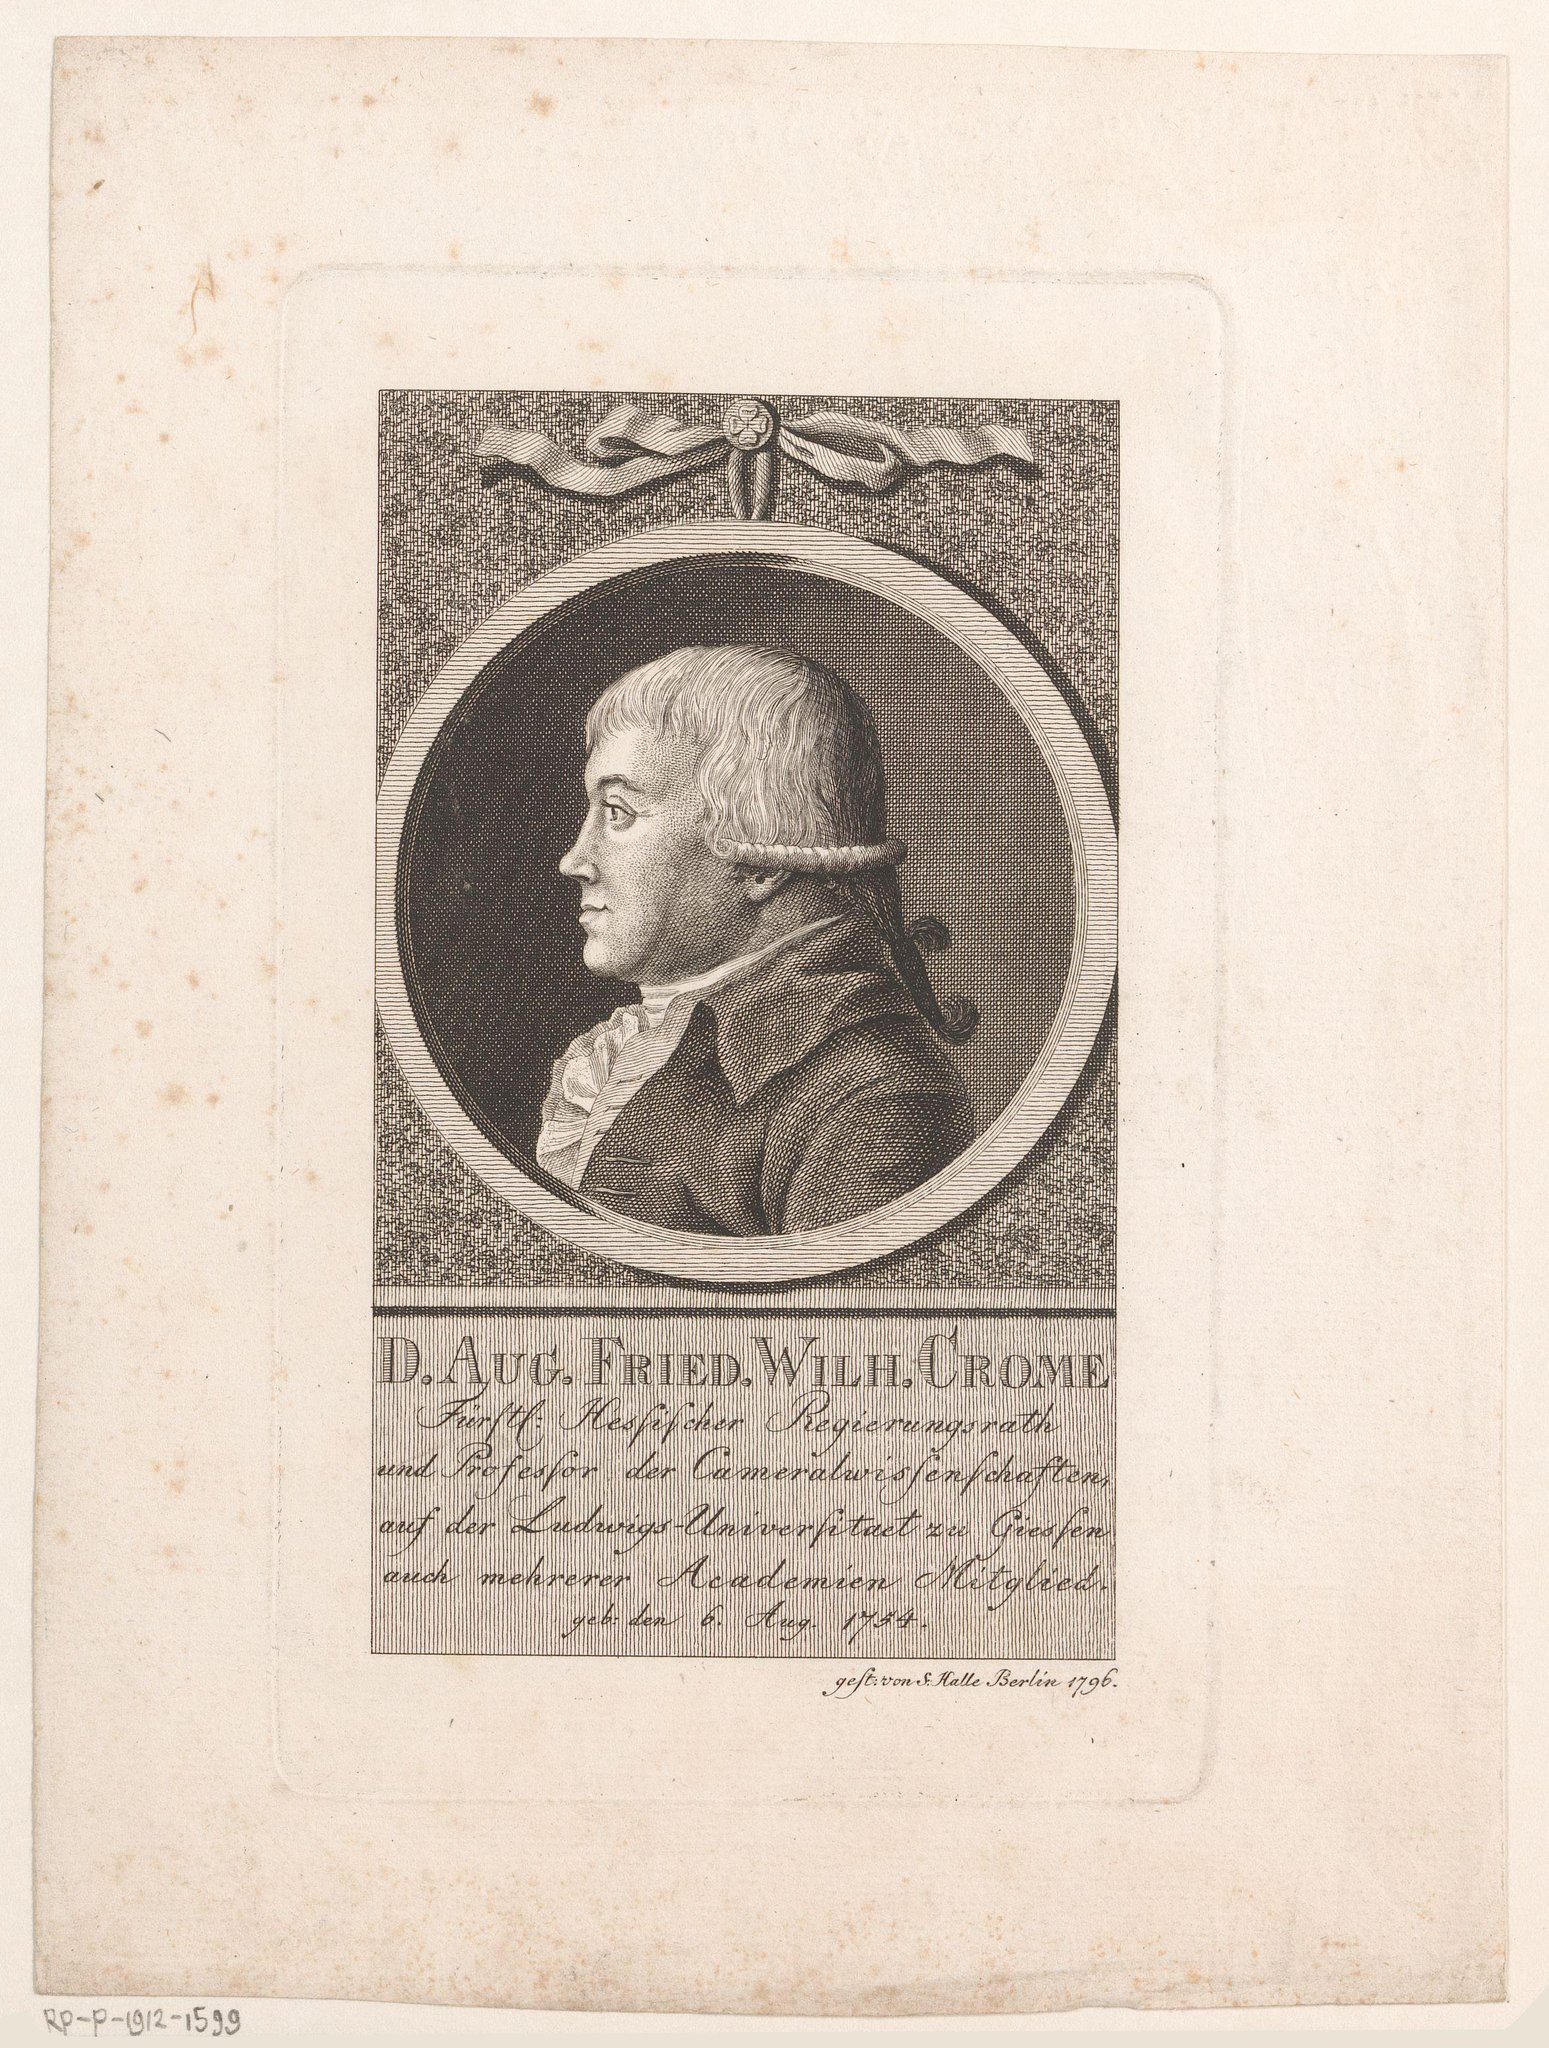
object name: print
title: Portret van August Friedrich Wilhelm Crome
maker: johann samuel ludwig halle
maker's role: print maker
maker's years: 1763-1829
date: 1796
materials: paper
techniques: engraving, etching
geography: berlin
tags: ornament ~ medallion, historical persons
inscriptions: collector's mark: Lugt 2228